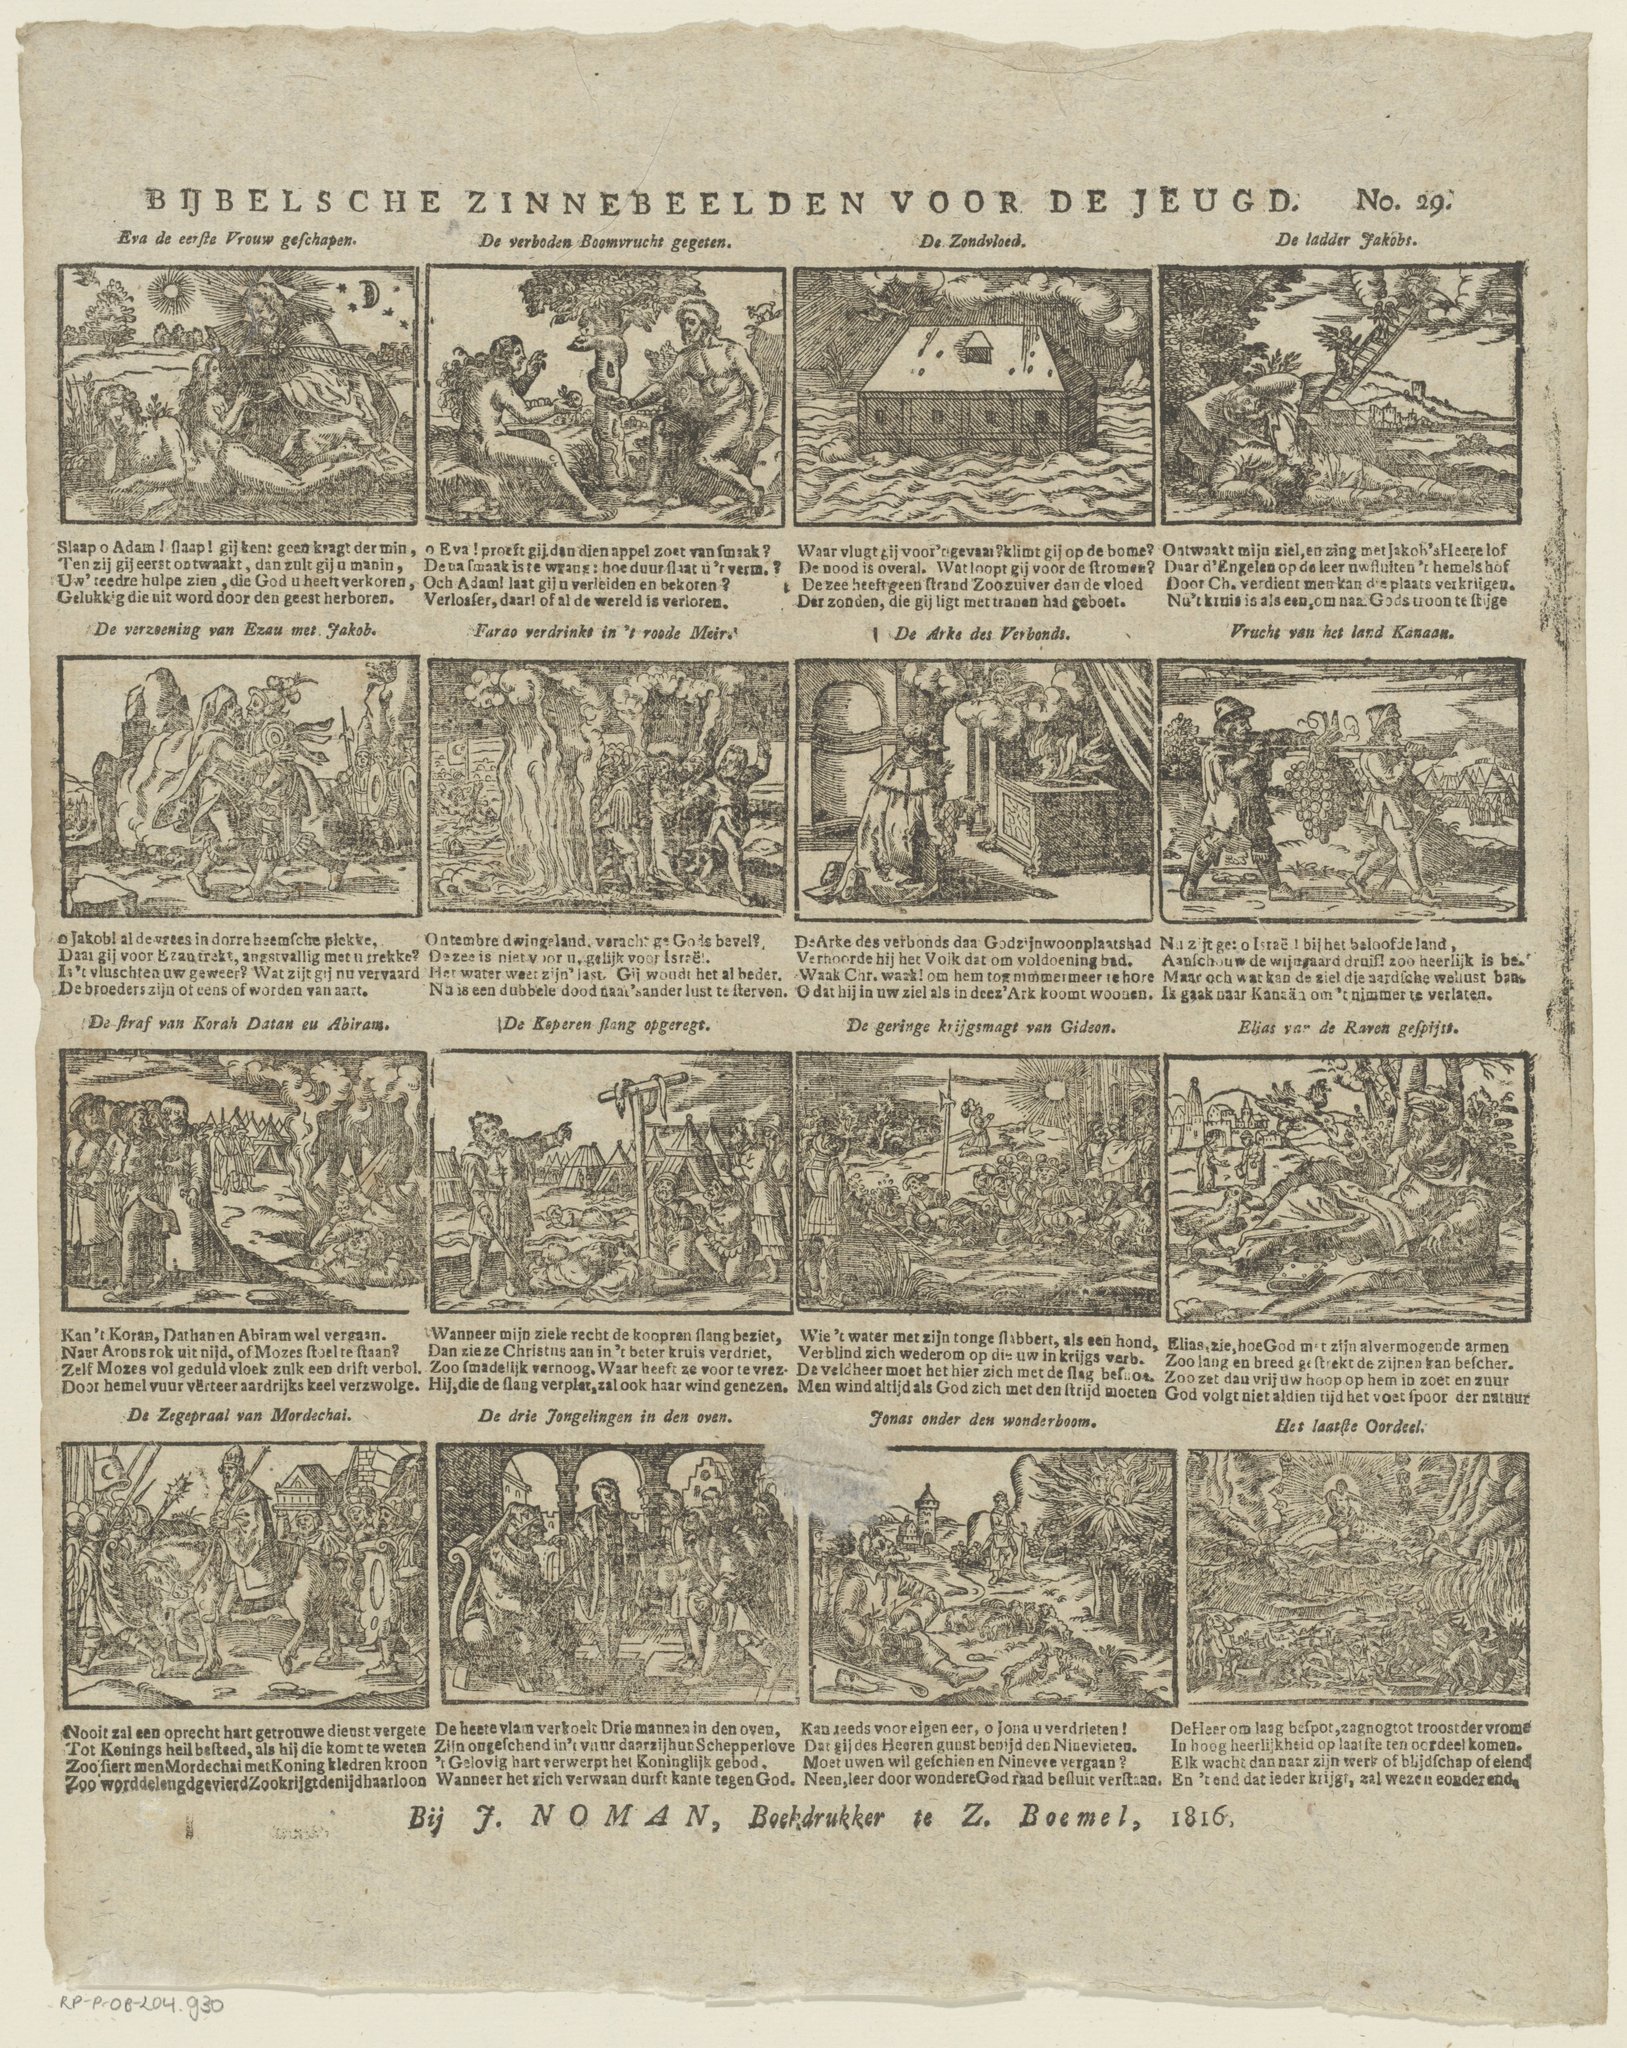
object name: popular print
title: Bijbelsche zinnebeelden voor de jeugd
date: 1806-1830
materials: paper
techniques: letterpress printing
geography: zaltbommel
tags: the revelation of john, the apocalypse, new testament, old testament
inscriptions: collector's mark: Lugt 2760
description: Blad met 16 voorstellingen van verhalen uit het Oude en het Nieuwe Testament. Onder elke afbeelding een onderschrift, boven elke afbeelding een titel. Genummerd rechtsboven: No. 29.